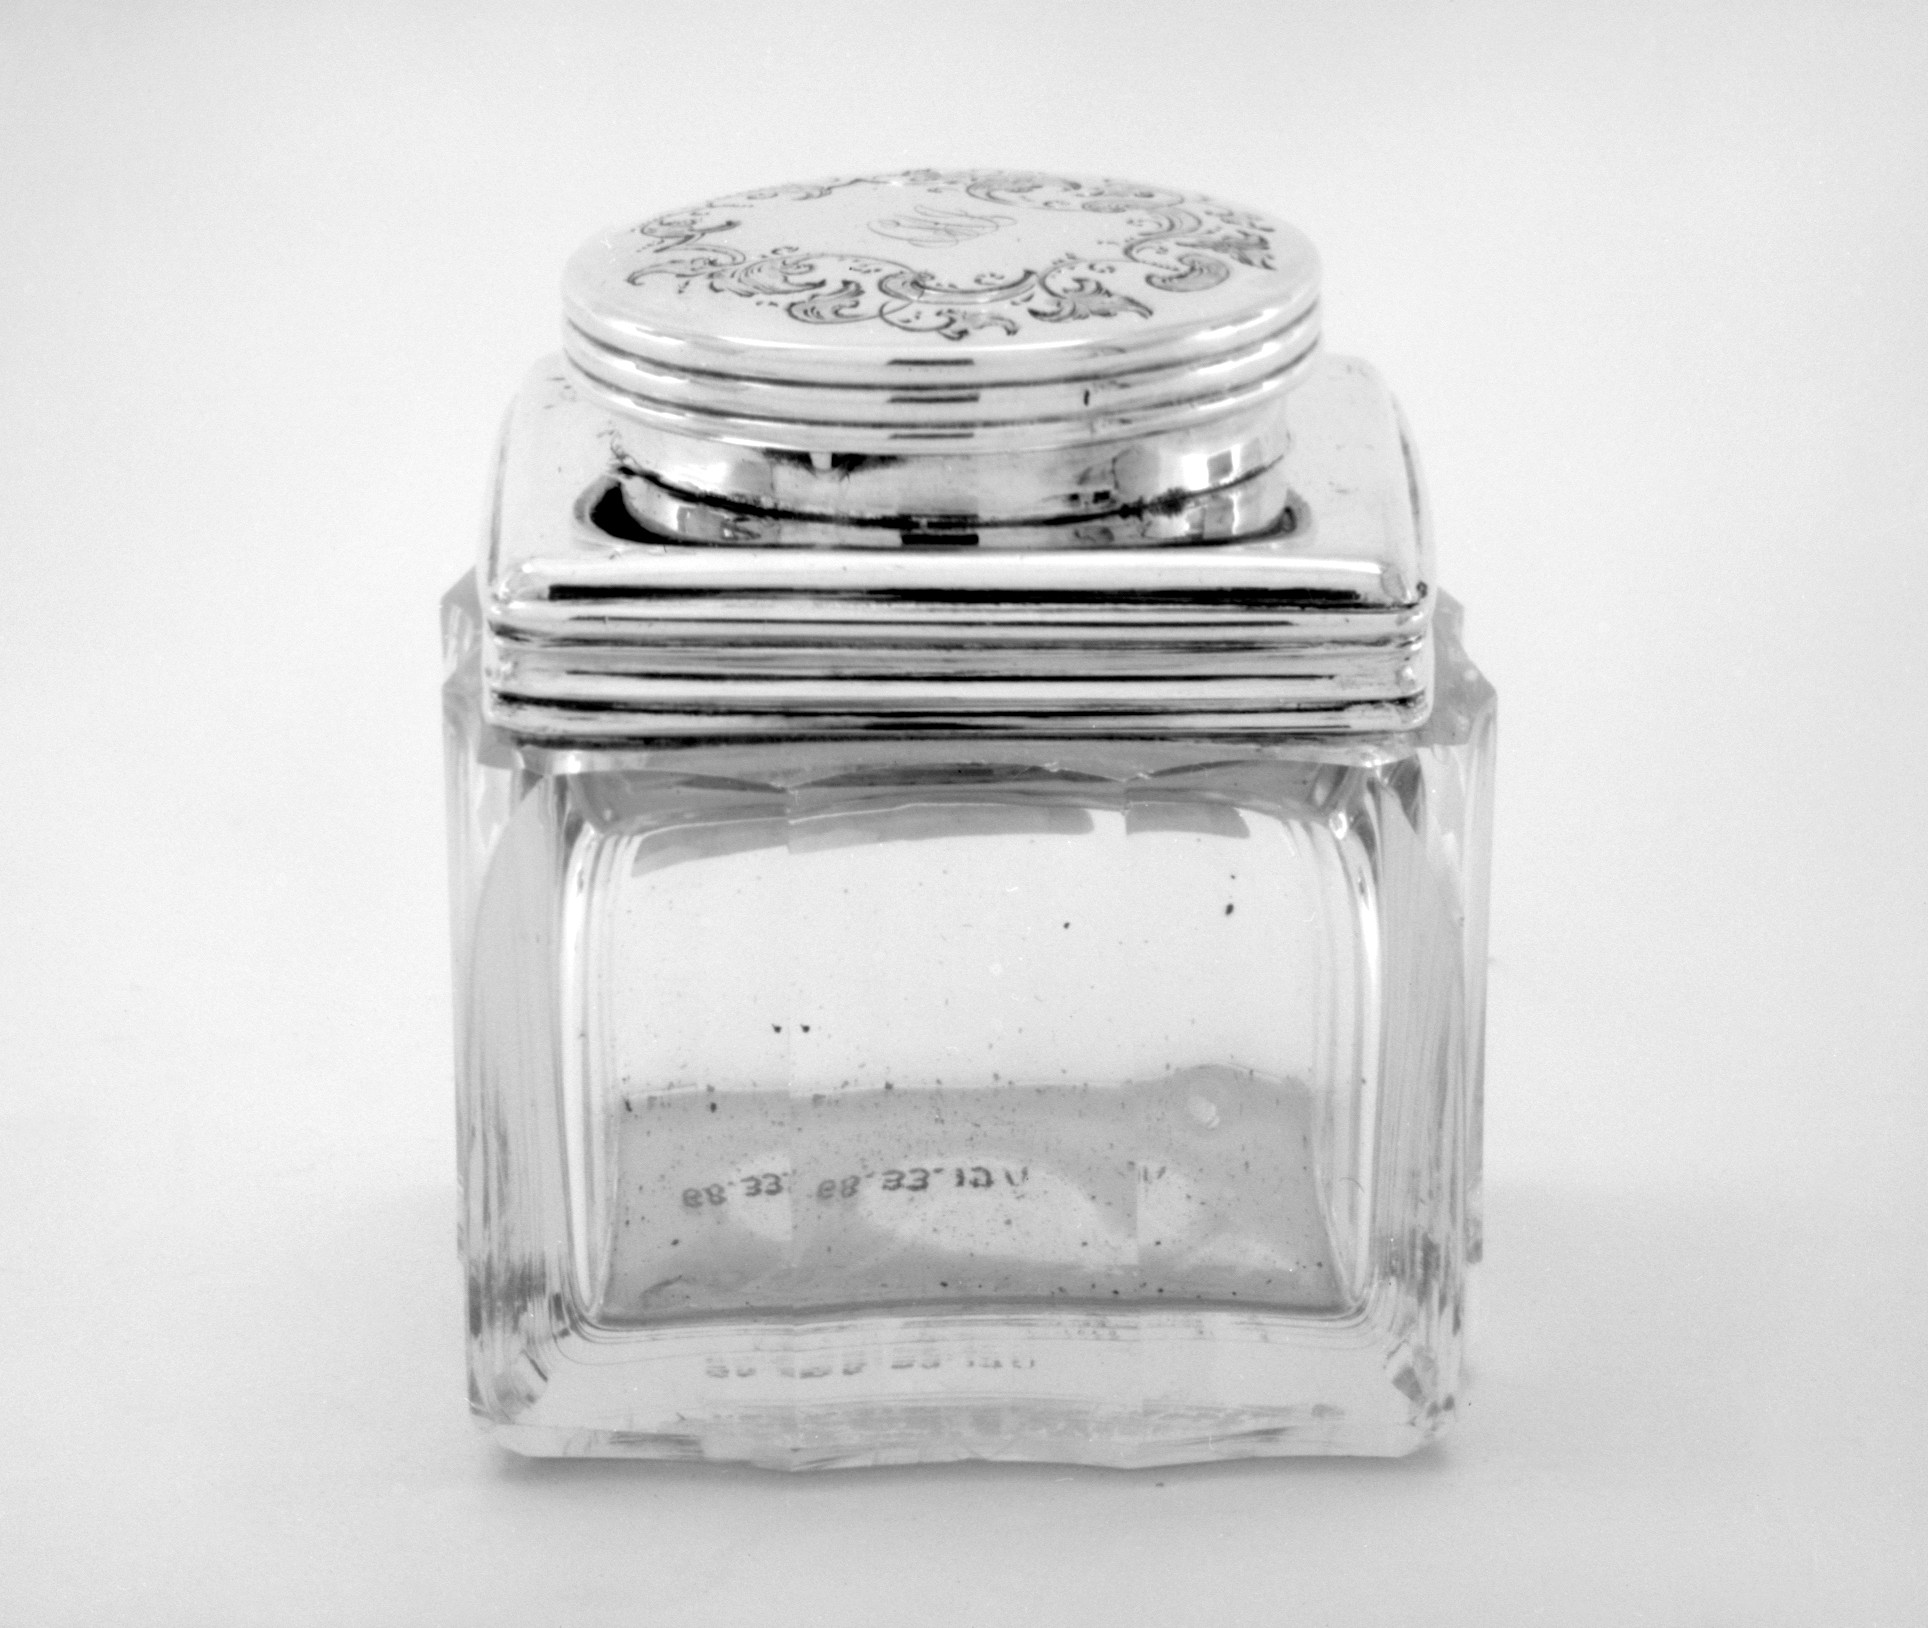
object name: pounce shaker with cover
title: Pounce shaker with cover (part of a set)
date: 1848-1849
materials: crystal, silver